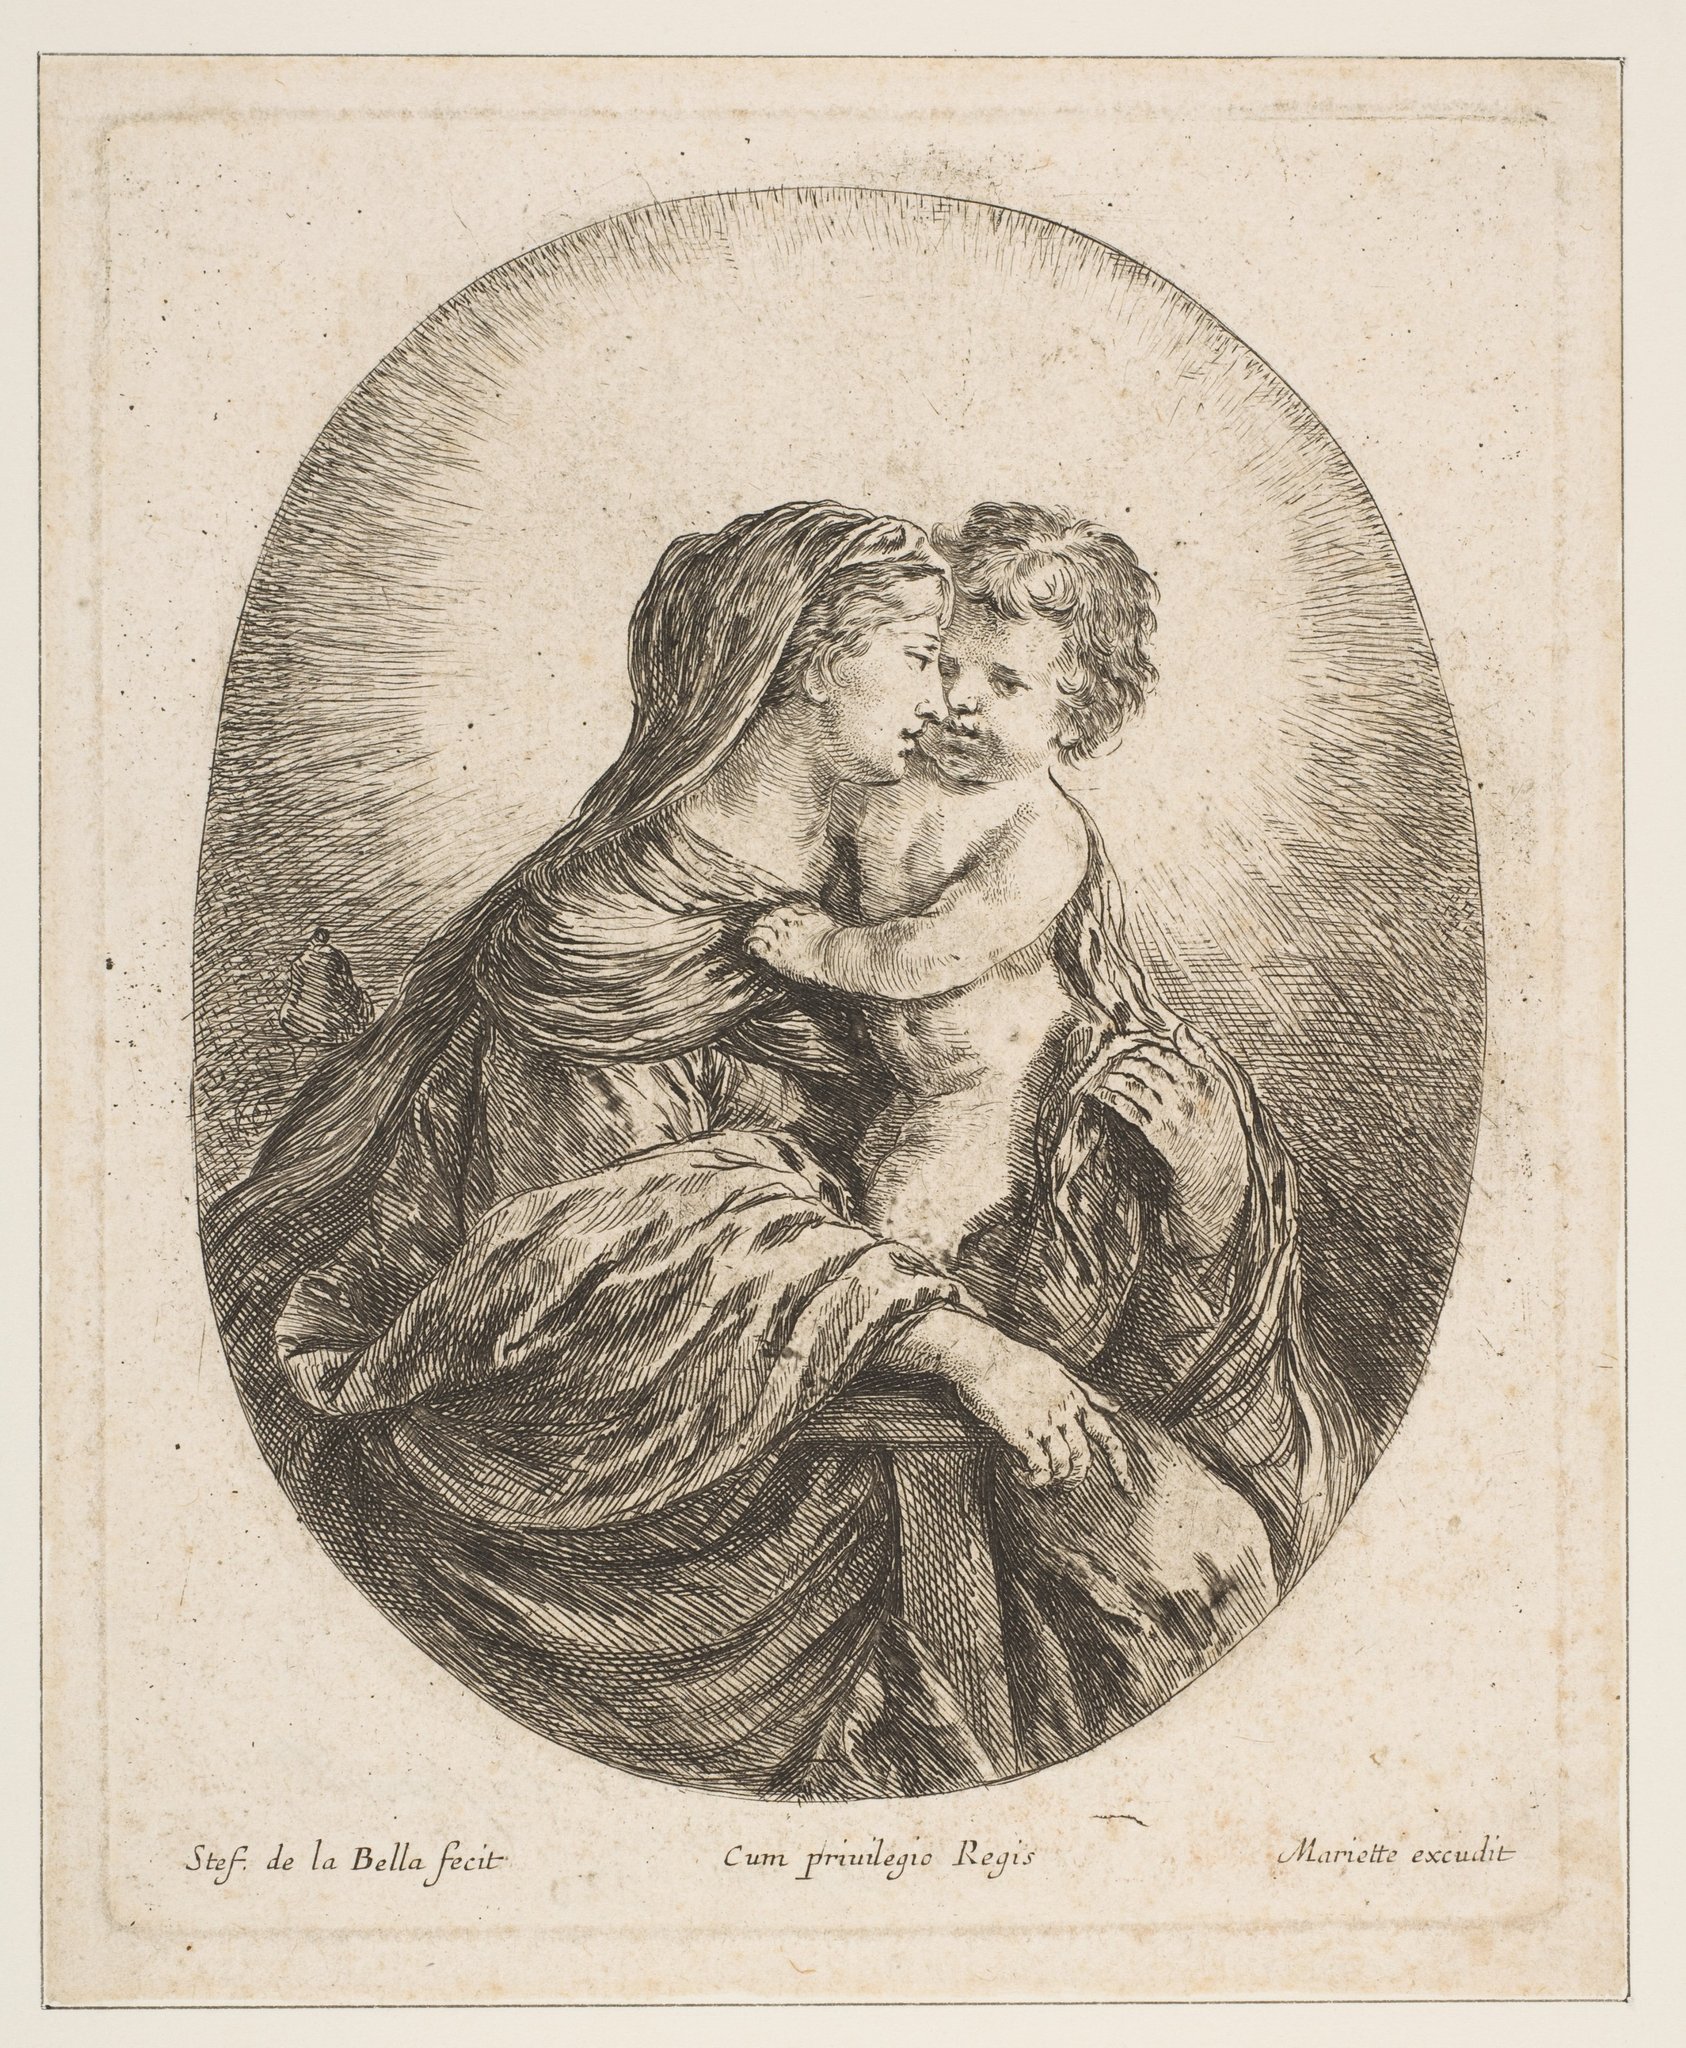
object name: print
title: The Virgin and Child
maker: stefano della bella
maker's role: artist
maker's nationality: italian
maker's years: 1610-1664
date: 1641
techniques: etching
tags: madonna and child